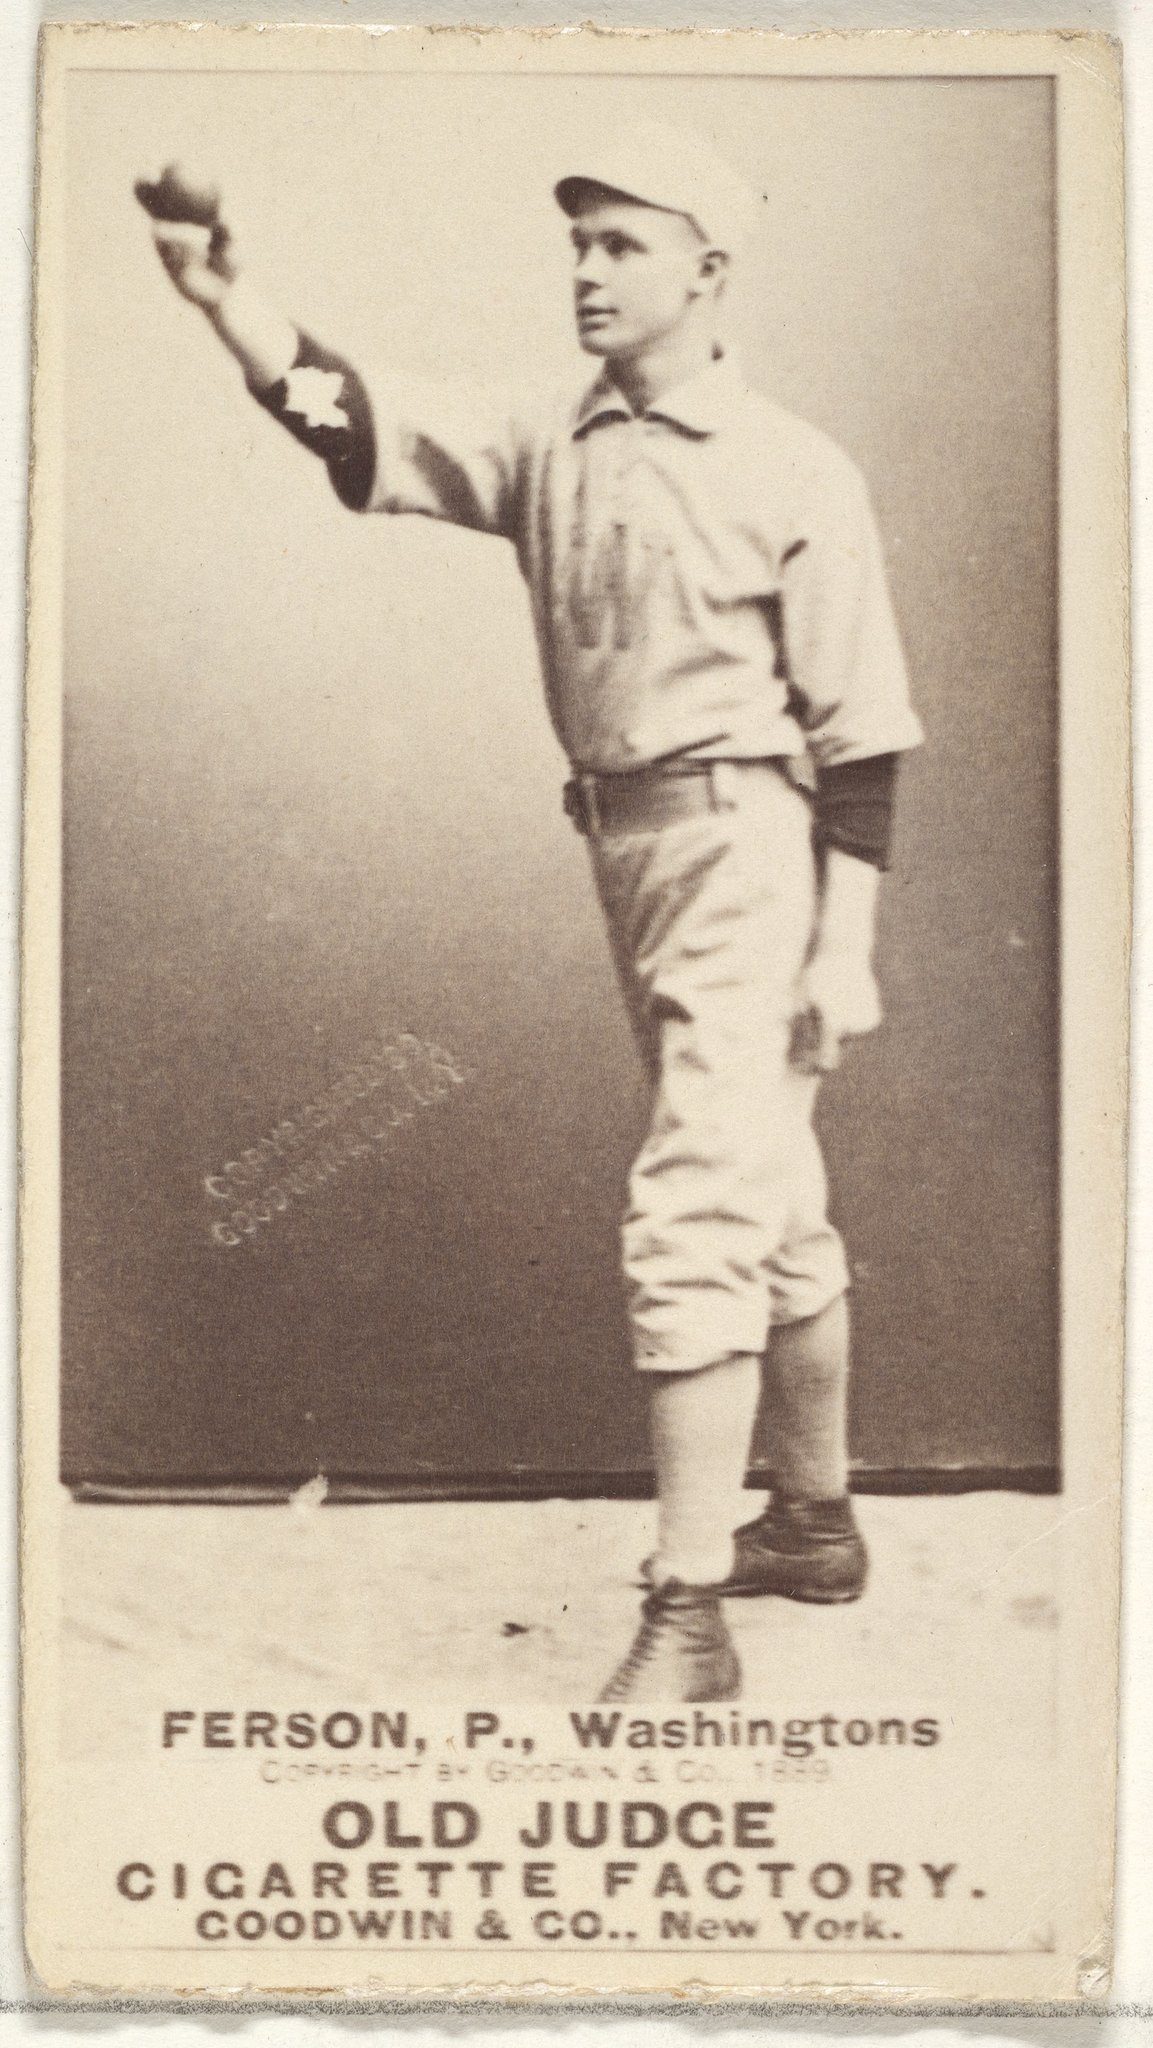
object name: baseball card, photograph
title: Alexander "Colonel" Ferson, Pitcher, Washington Nationals, from the Old Judge series (N172) for Old Judge Cigarettes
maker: goodwin & company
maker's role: publisher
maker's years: 1850-1950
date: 1889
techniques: albumen silver print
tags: men,portraits,baseball,athletes